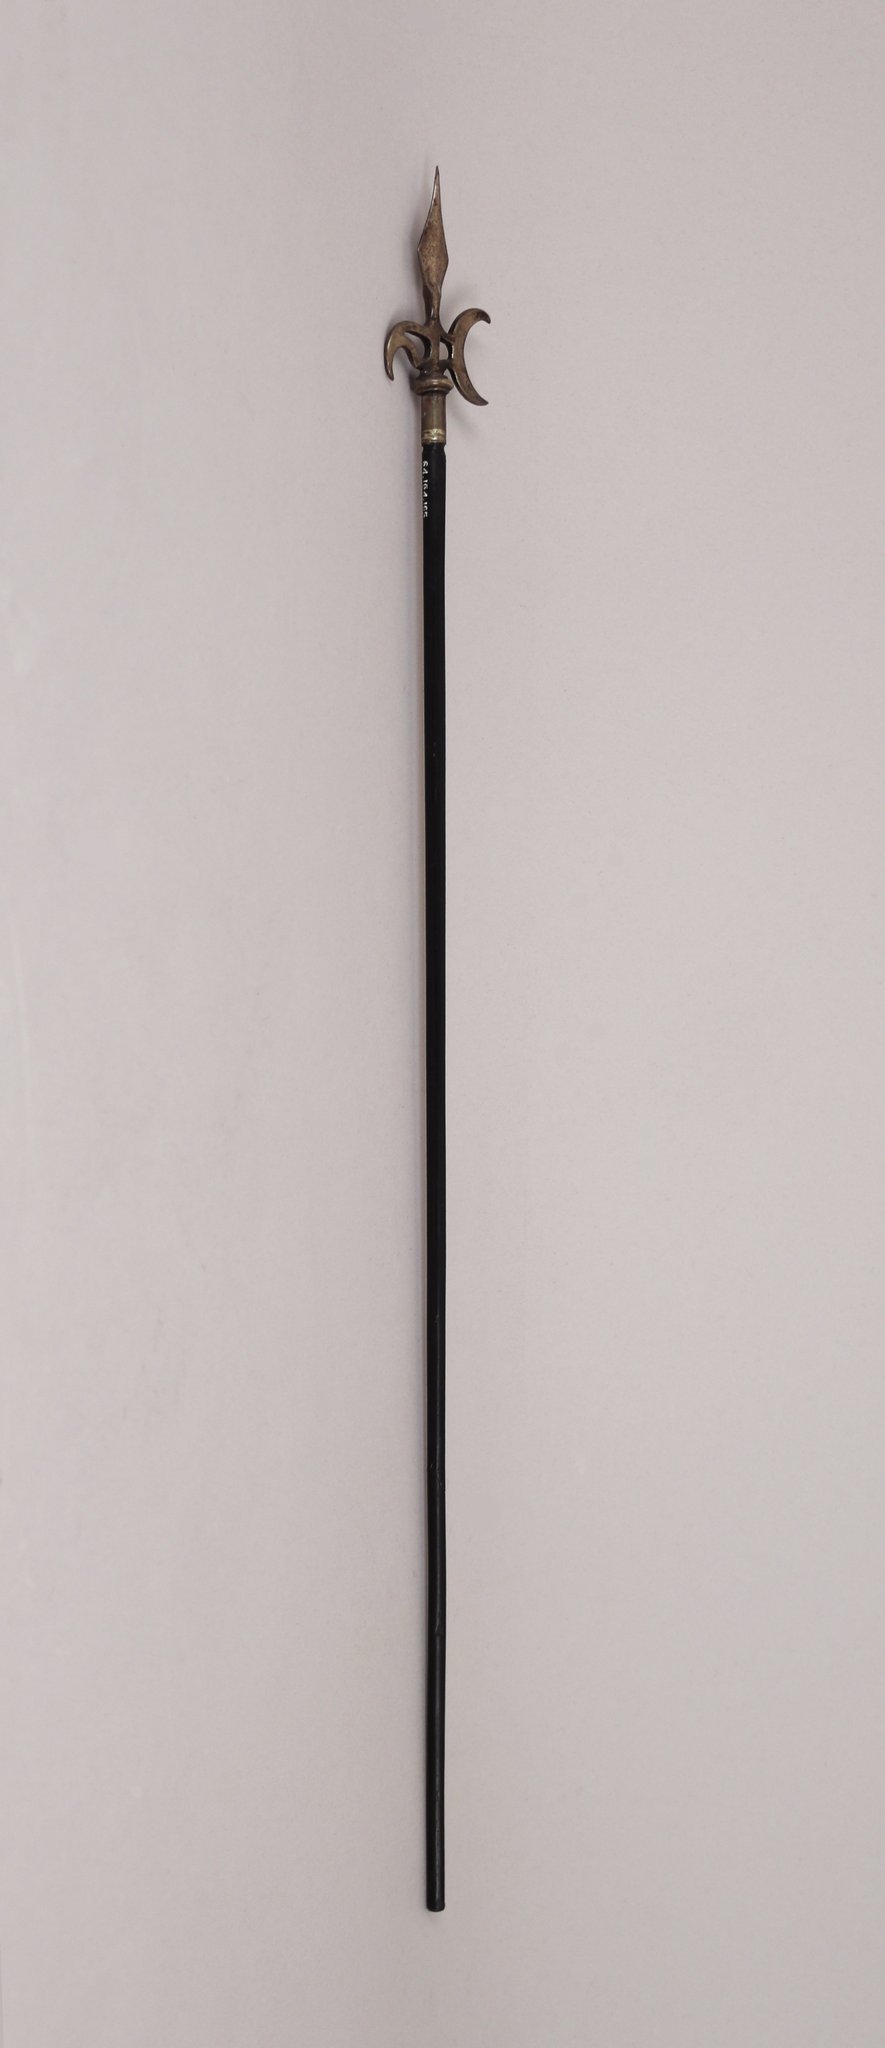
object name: crèche accessory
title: Halberd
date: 1701-1800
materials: steel, wood